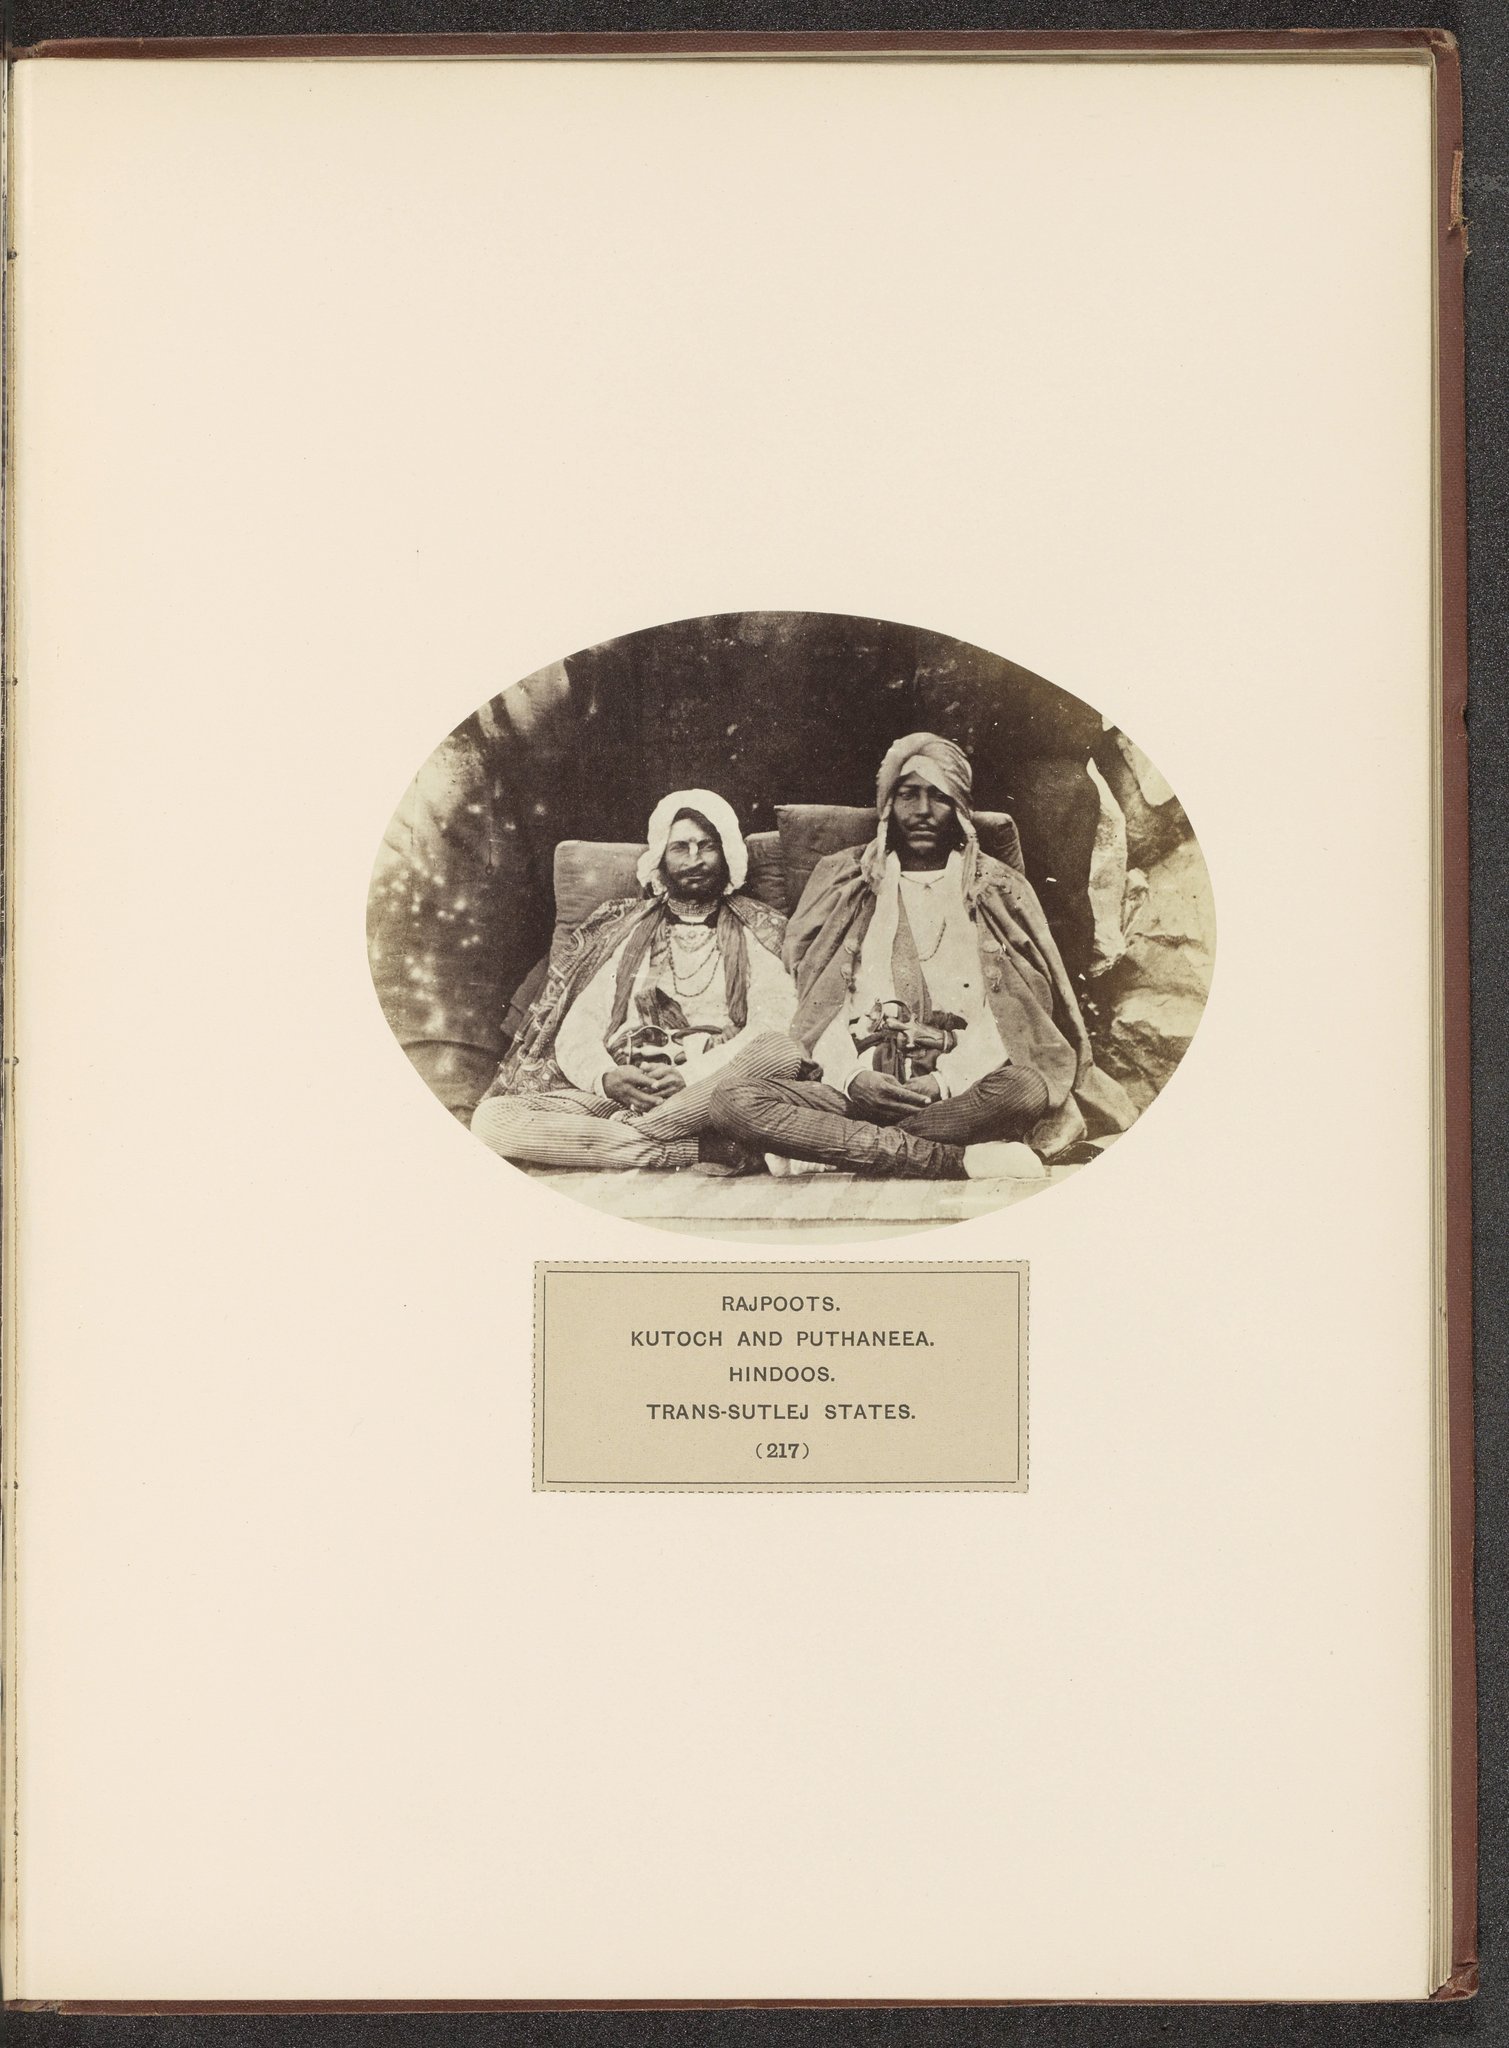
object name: page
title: Portrait of two unknown men from the Rajput community of Kangra, Himachal Pradesh, India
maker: Anonymous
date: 1859-1869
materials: photographic support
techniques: albumen print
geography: kangra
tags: head-gear: turban, human races; peoples; nationalities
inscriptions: number: ‘(217)’, inscription: ‘RAJPOOTS./ KUTOCH AND PUTHANEEA./ HINDOOS./ TRANS-SUTLEJ STATES.’